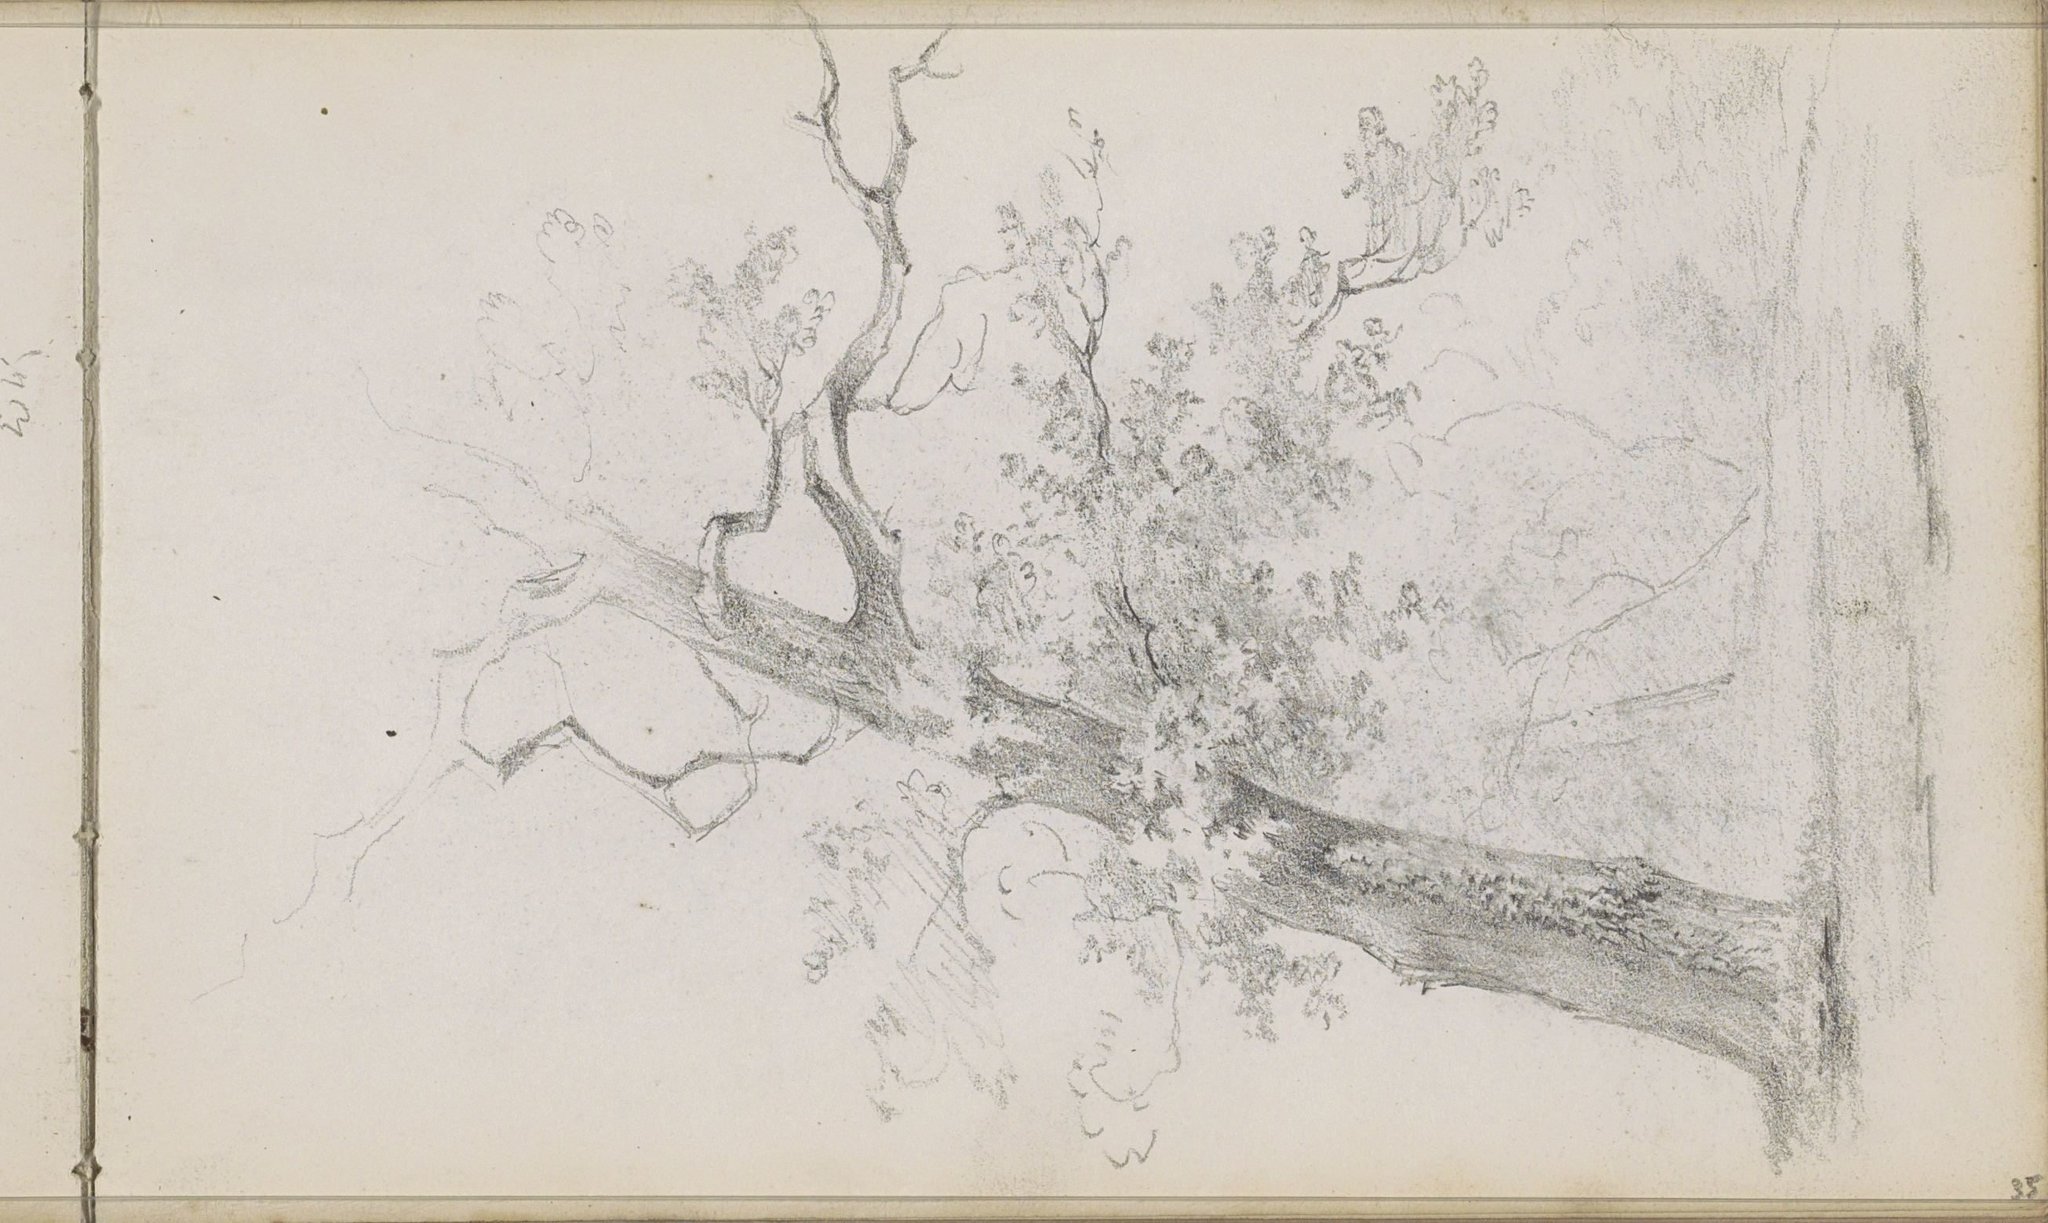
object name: sketchbook leaf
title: Overhellende boom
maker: willem cornelis rip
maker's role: draughtsman, painter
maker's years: 1856-1922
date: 1874-1875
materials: paper, pencil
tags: trees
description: Blad 35 recto uit een schetsboek met 46 bladen.